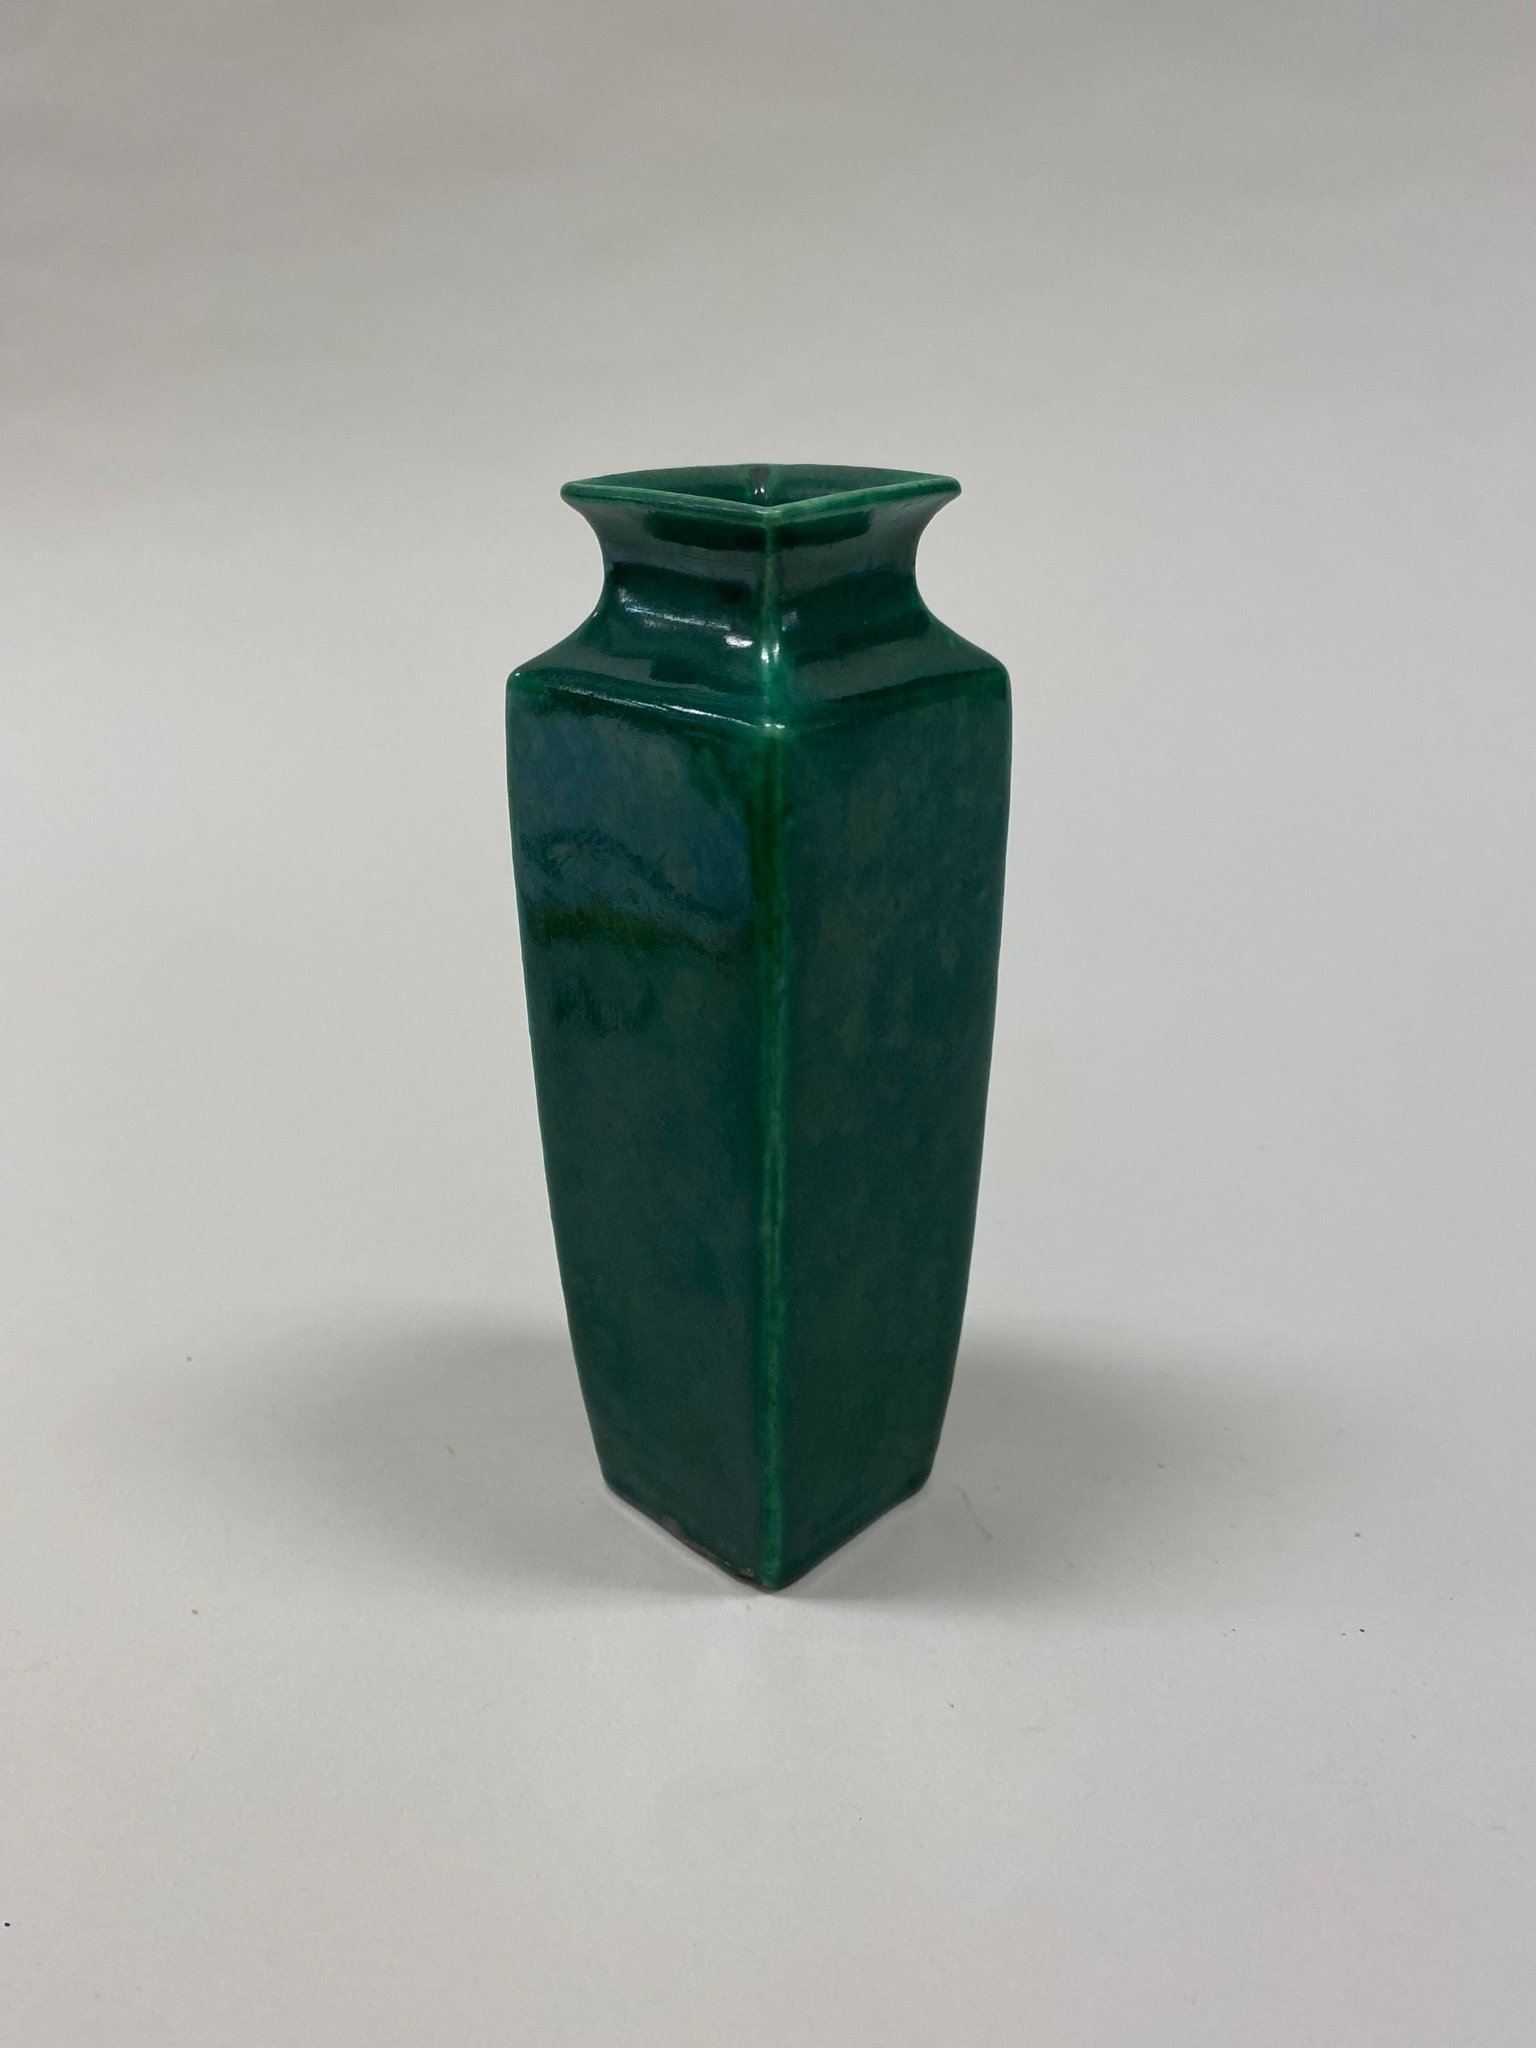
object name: vase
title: Square vase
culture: chinese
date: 1767-1900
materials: glaze, porcelain